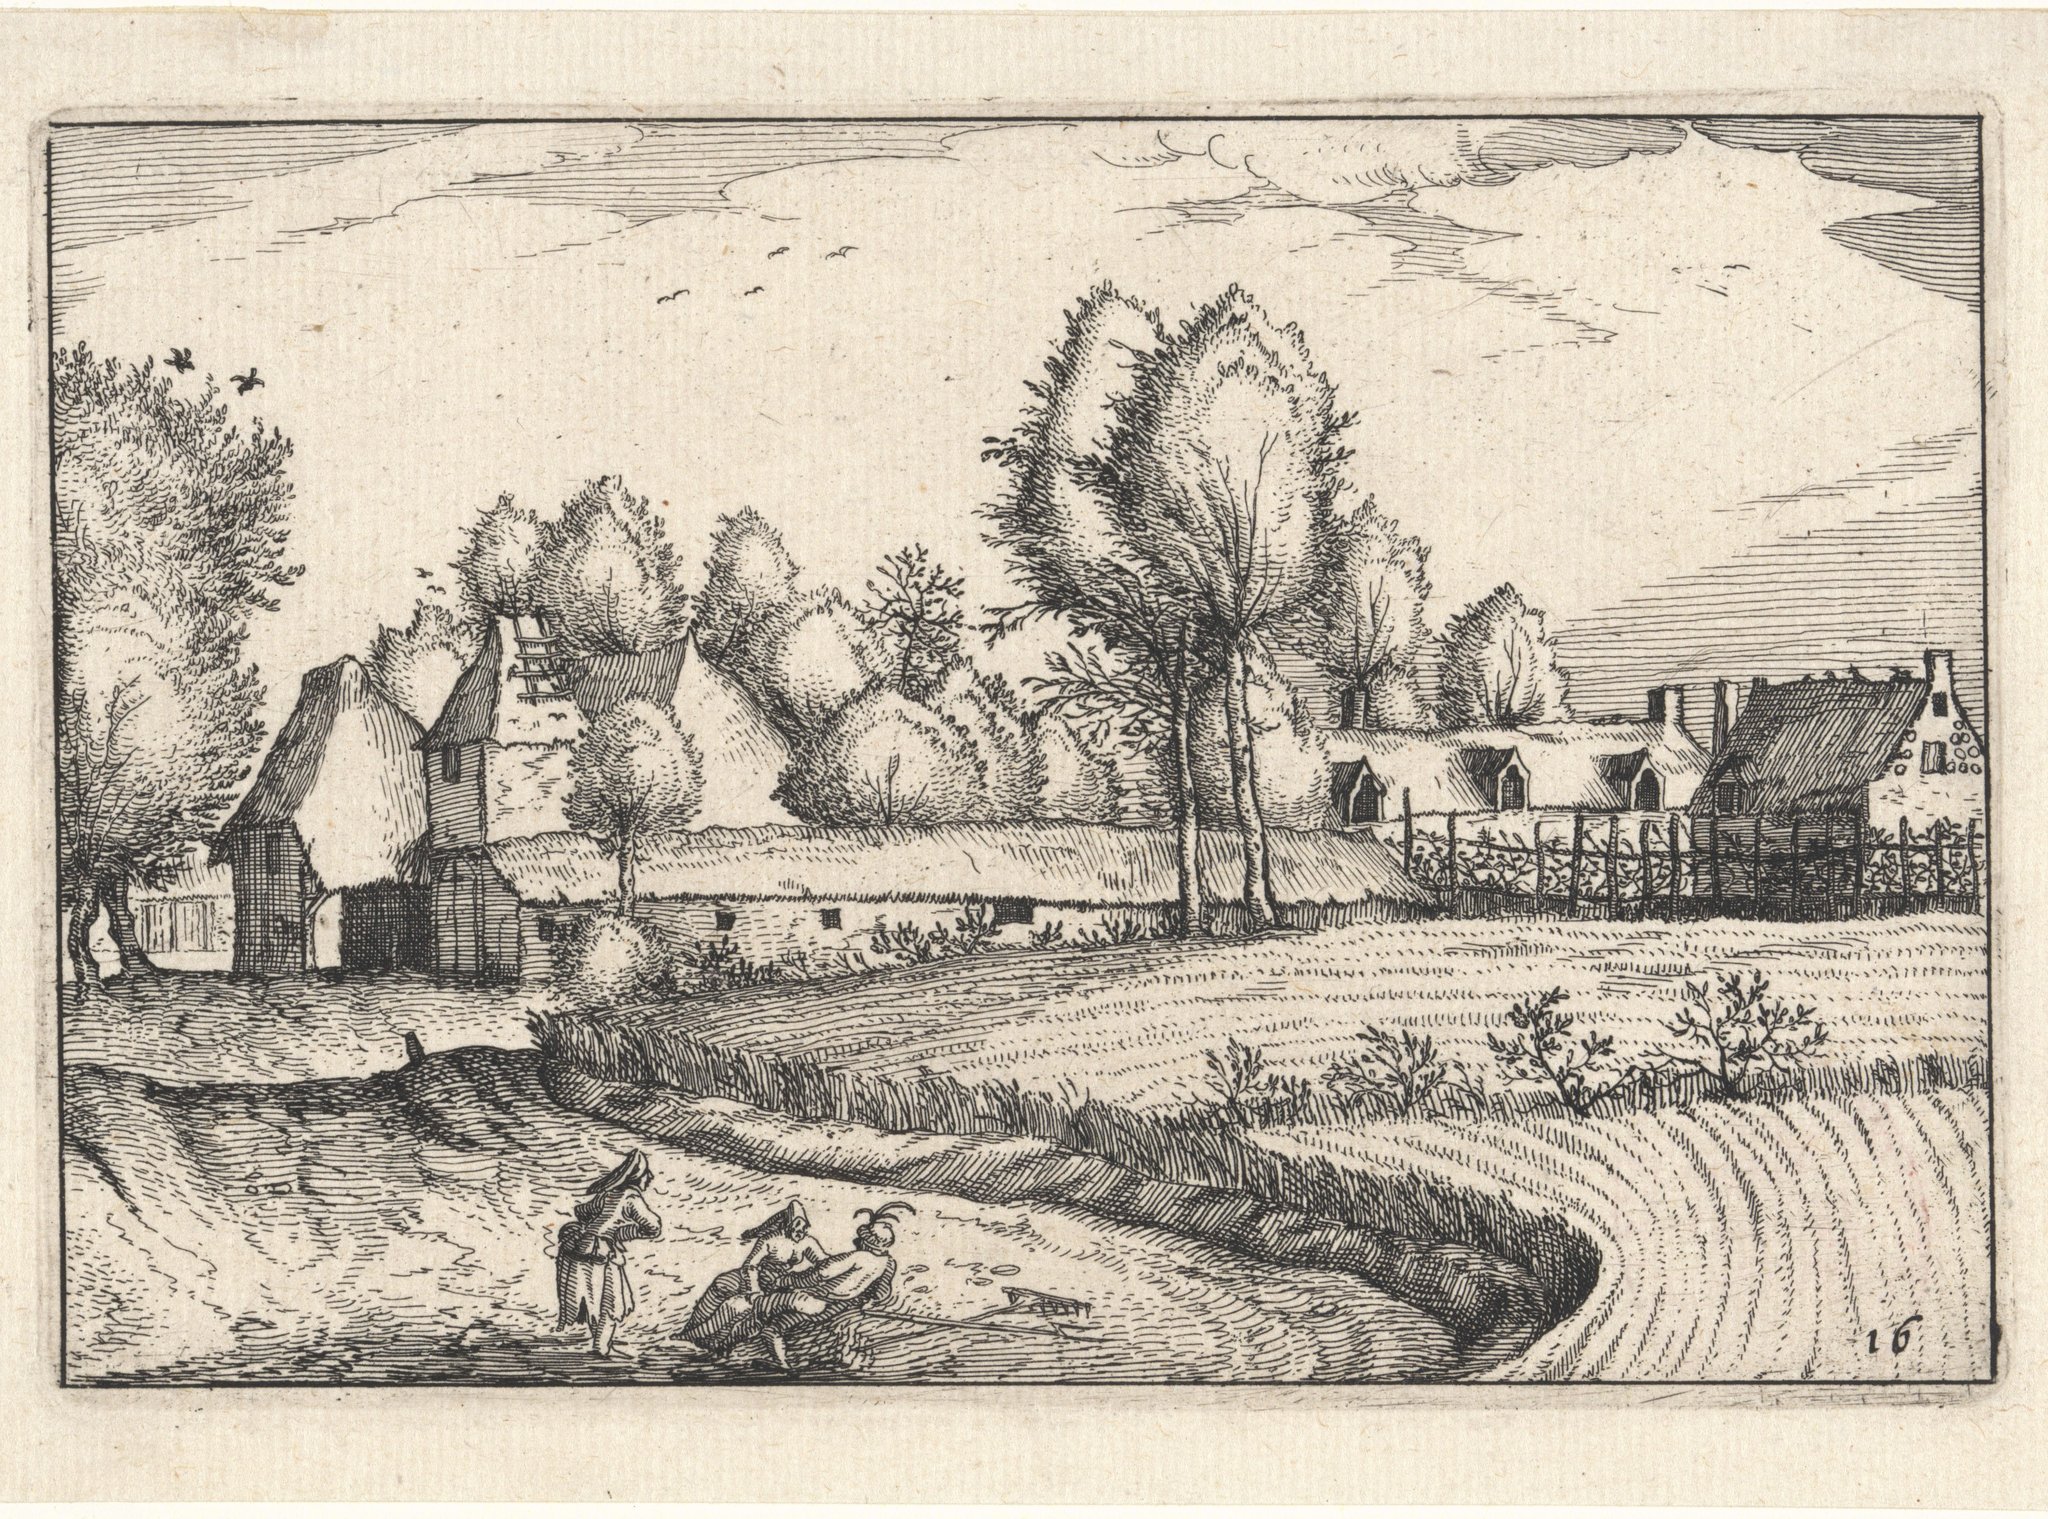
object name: print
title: Landschappen met gebouwen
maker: claes jansz. visscher (ii)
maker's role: draughtsman, print maker, publisher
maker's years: 1586-1652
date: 1620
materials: paper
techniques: etching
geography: amsterdam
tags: field filled with a crop, farm or solitary house in landscape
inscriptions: collector's mark: Lugt 240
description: Gezicht op een veld waar een weg langs loopt, met op de voorgrond drie figuren. Op de achtergrond een groep huizen.